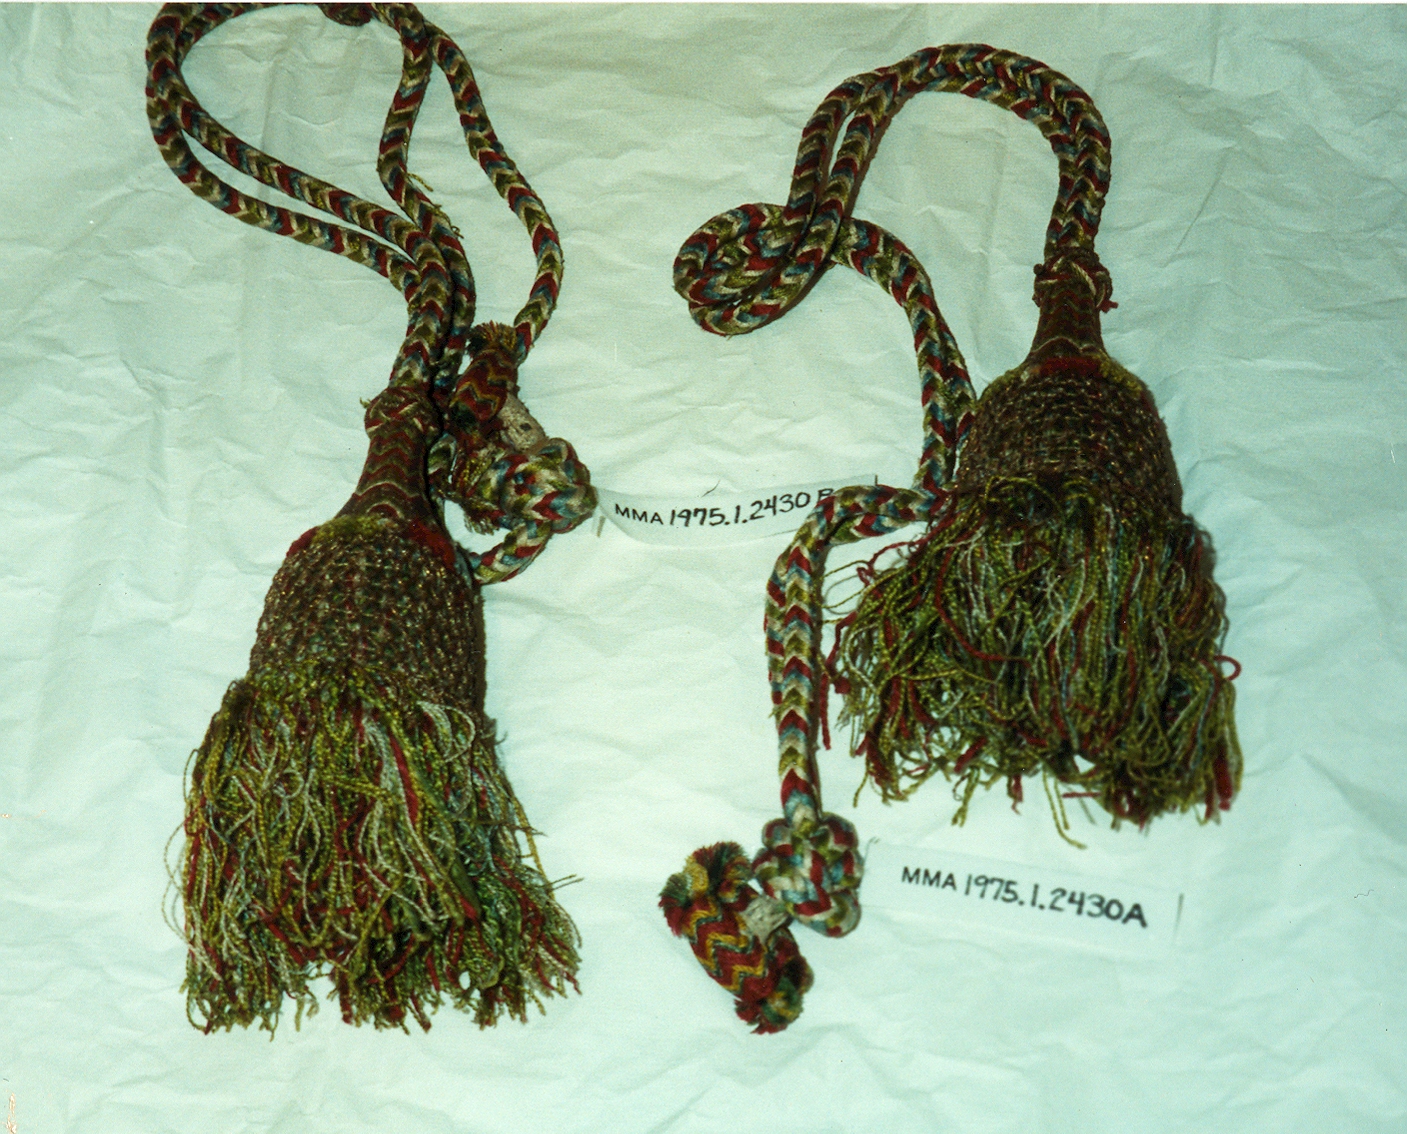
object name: tassel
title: Pair of tassels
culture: european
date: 1601-1900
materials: metal, silk